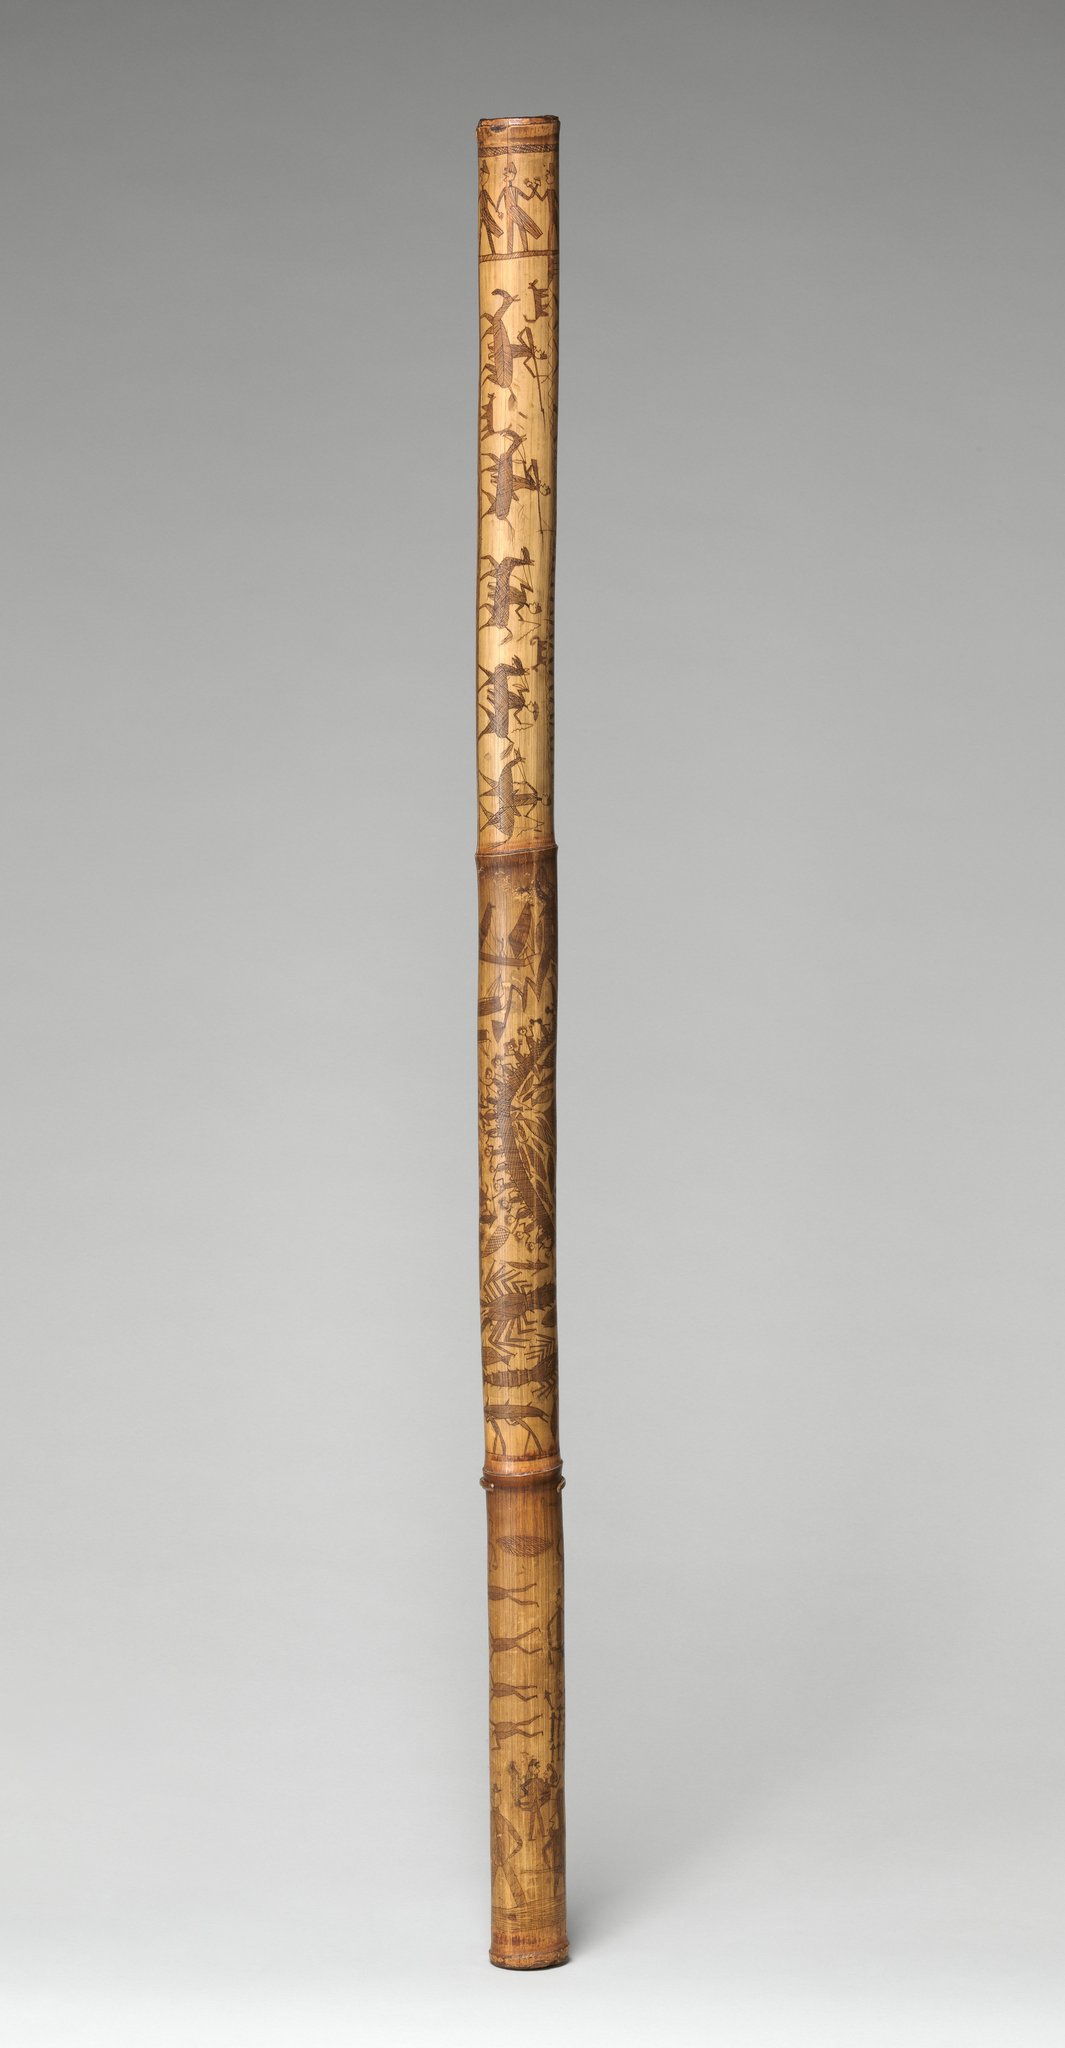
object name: container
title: Engraved Bamboo Container (Kare U Ta)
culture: kanak people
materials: bamboo, pigment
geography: new caledonia